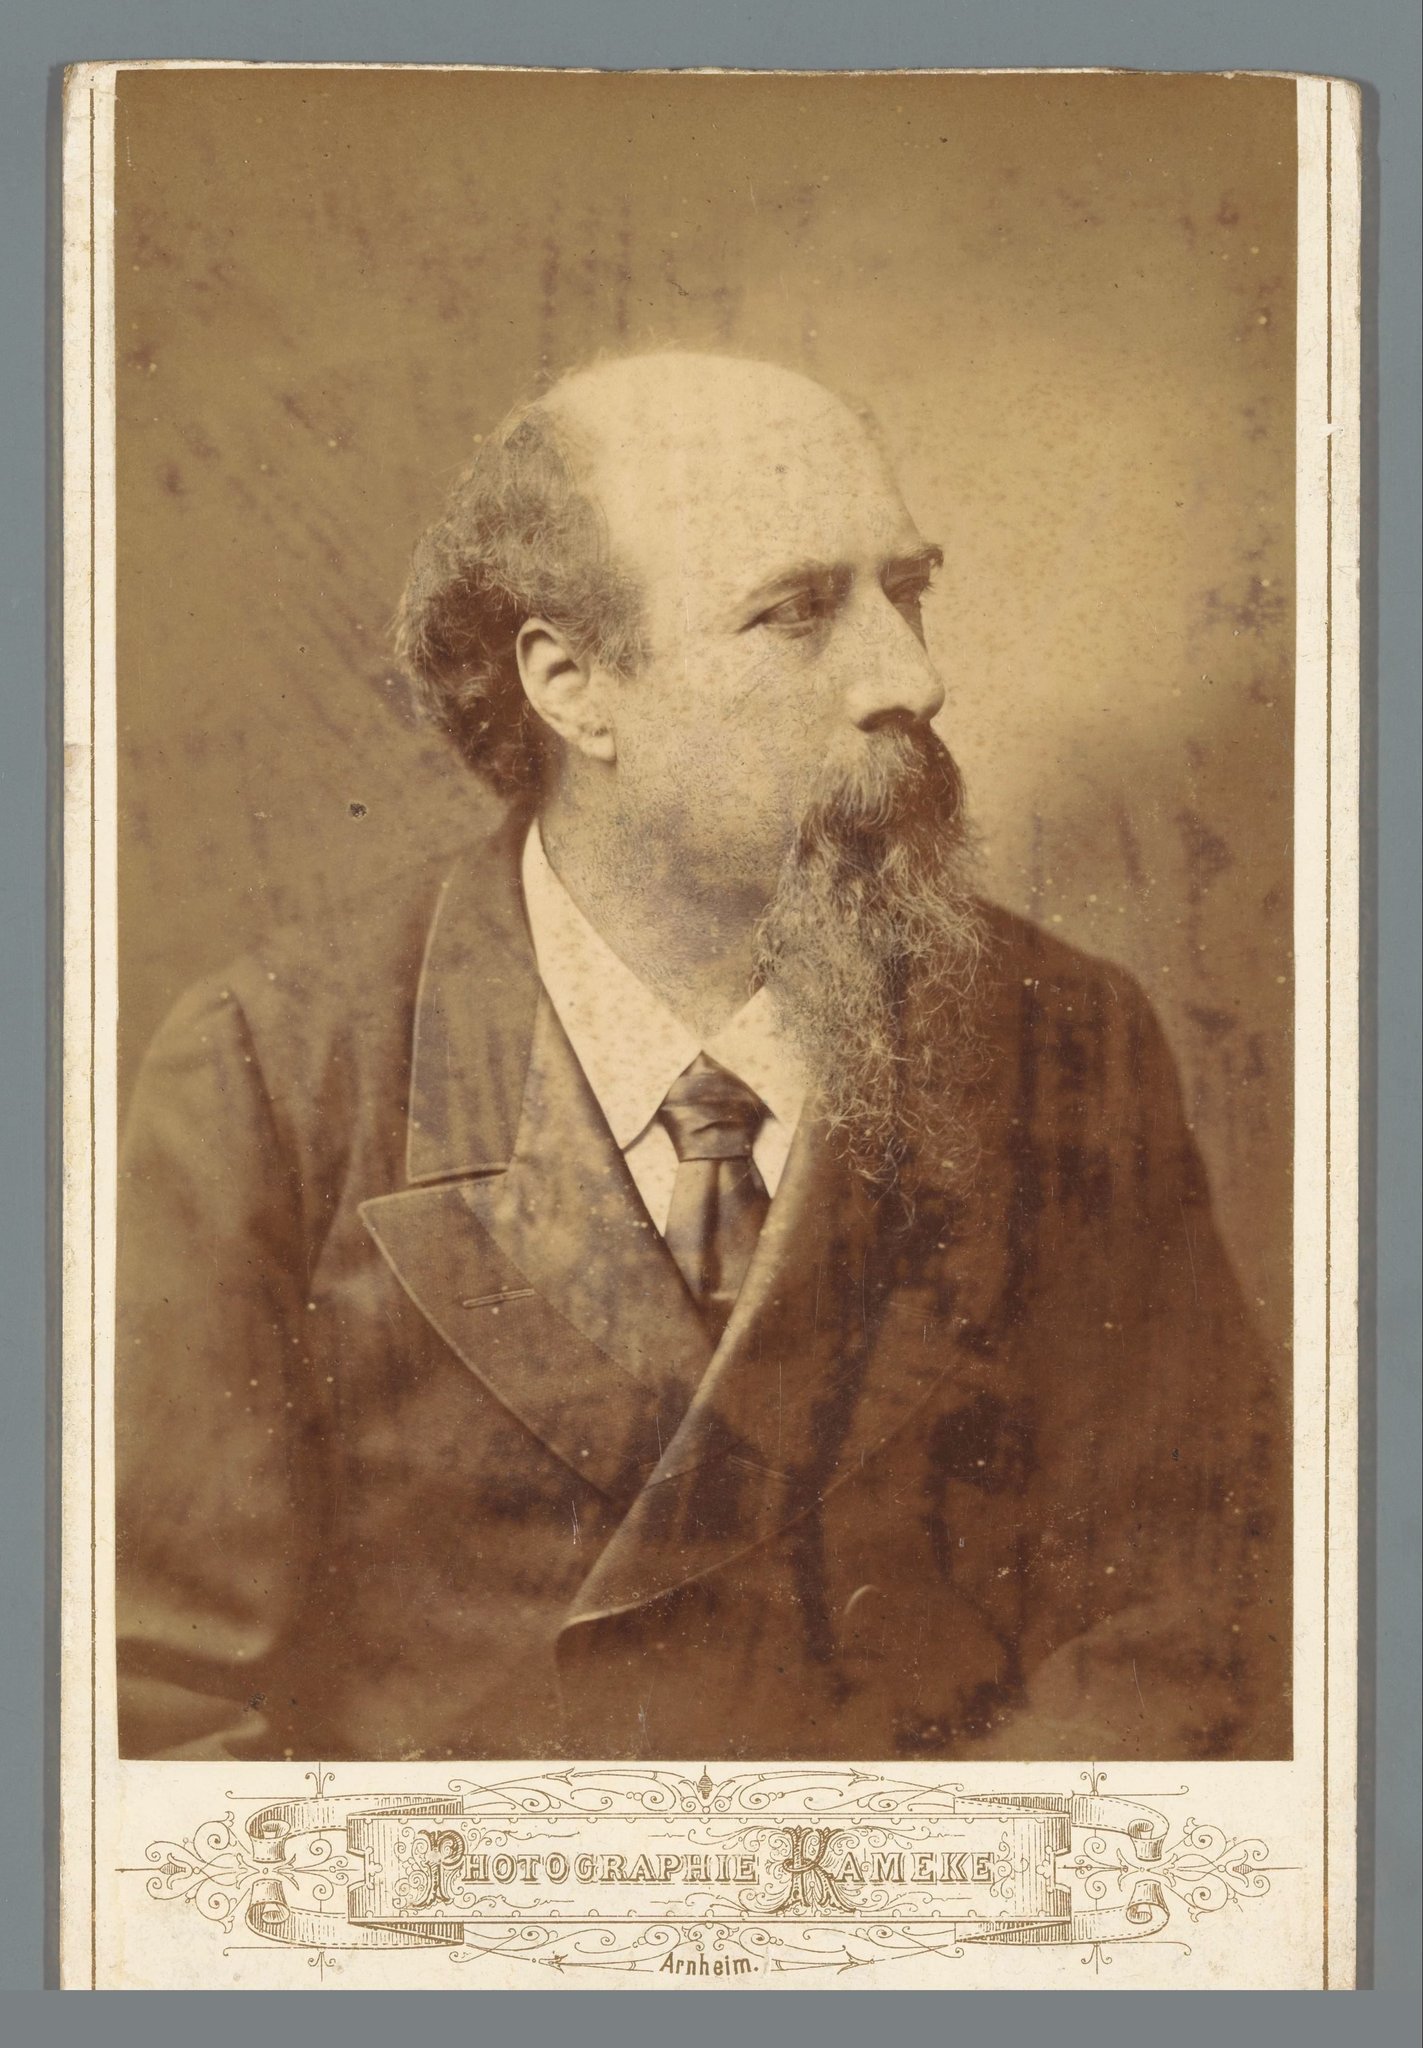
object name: cabinet photograph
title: Portret van een onbekende man met een baard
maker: richard kameke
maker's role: fotograaf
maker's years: 1847-1898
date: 1803-1881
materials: cardboard, photographic support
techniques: albumen print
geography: arnhem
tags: adult man, beard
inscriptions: name: ‘Kameke Peintre et artite photographe Arnheim près de la poste.’